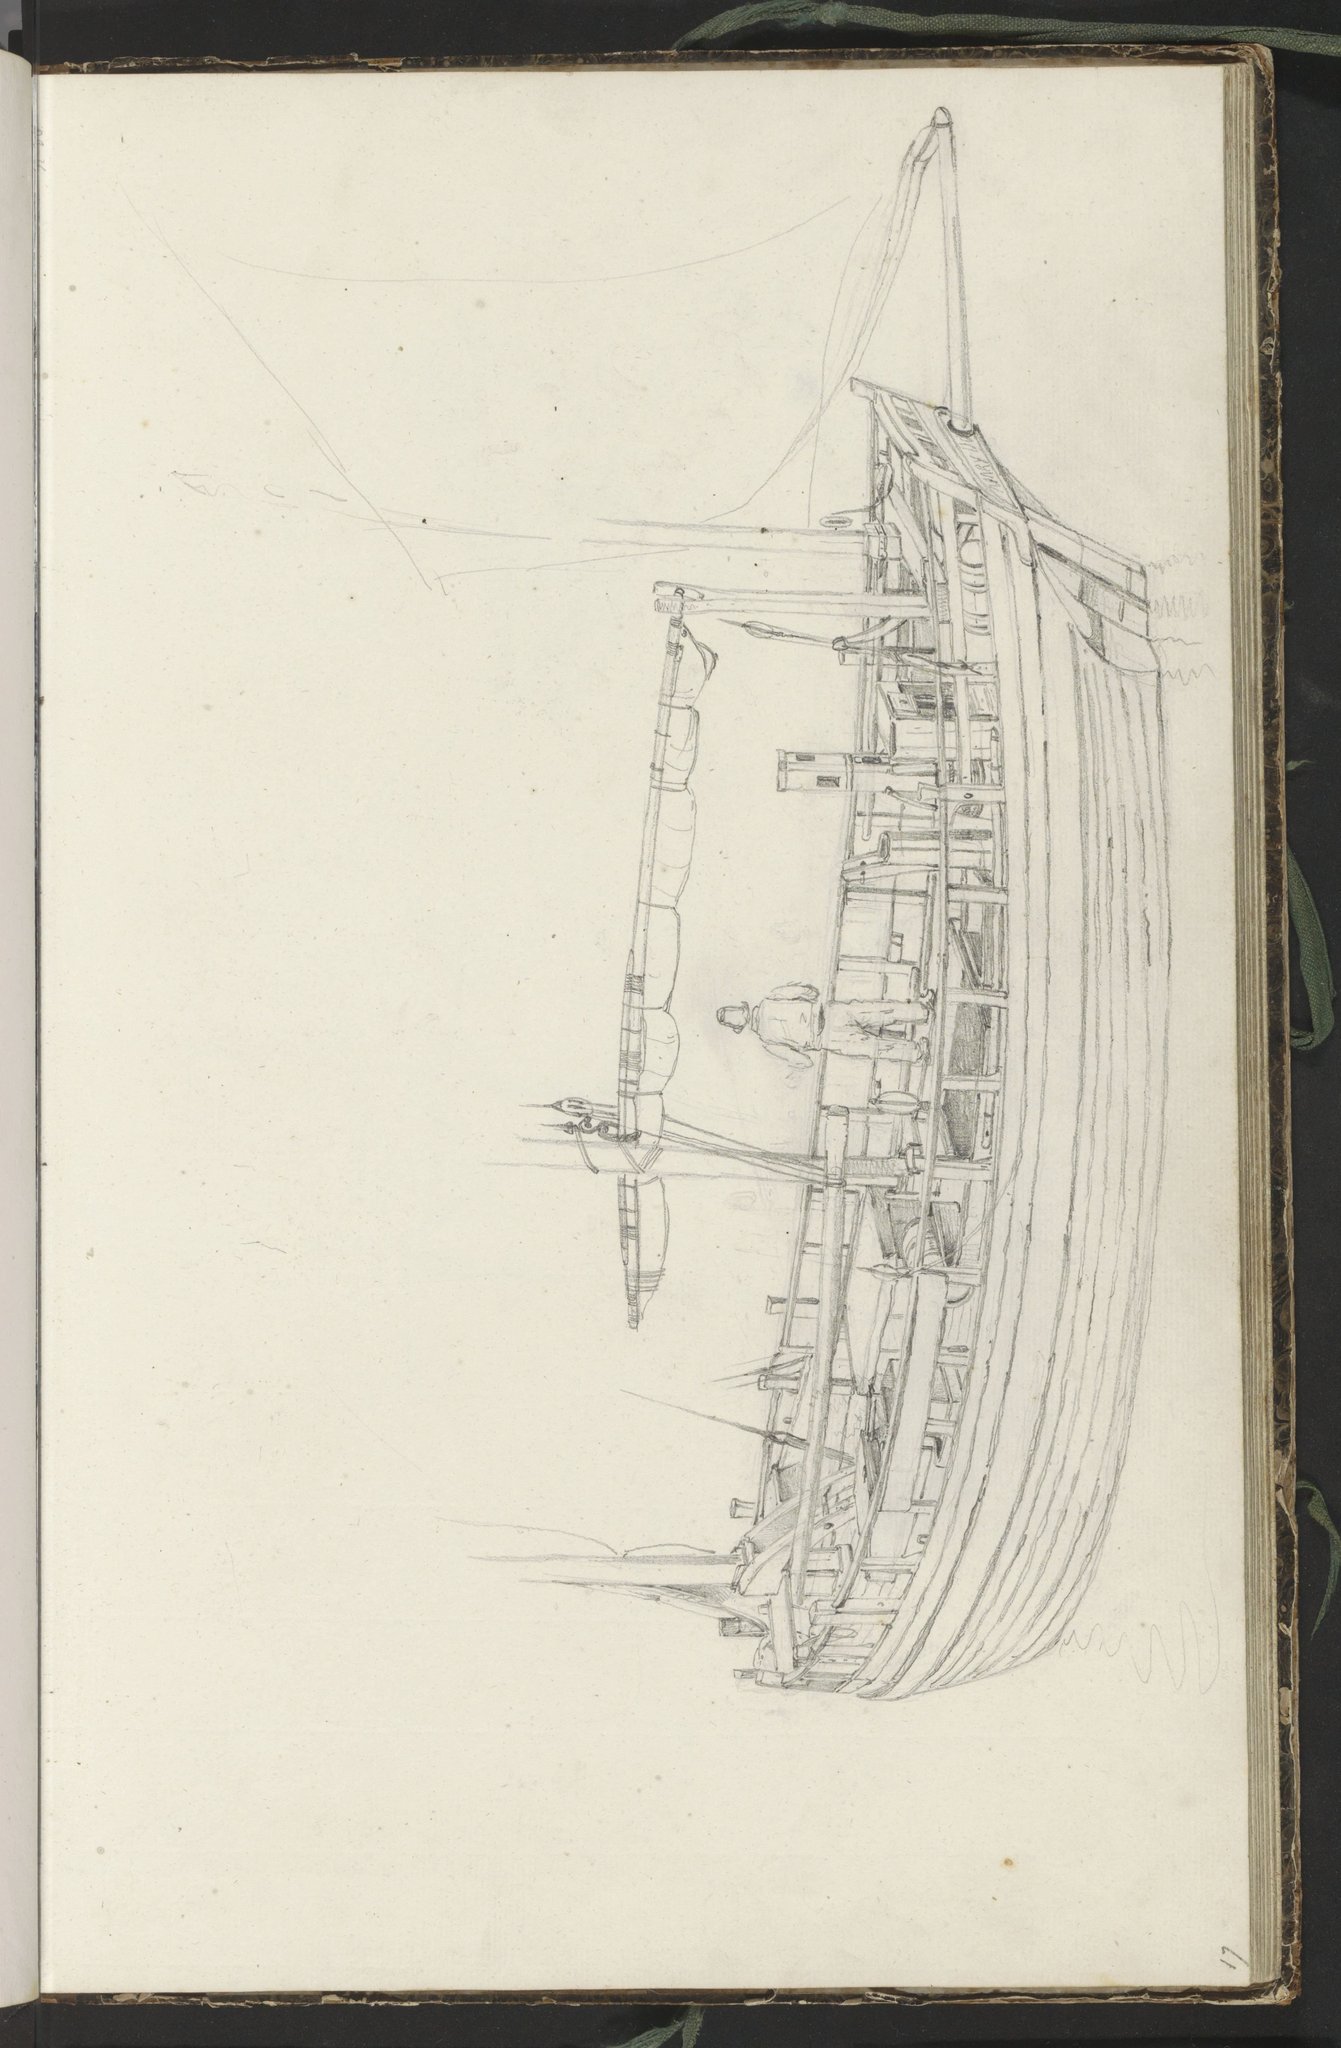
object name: sketchbook leaf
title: Man op een zeilschip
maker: johannes christiaan schotel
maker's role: draughtsman, painter, print maker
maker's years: 1787-1838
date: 1797-1838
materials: paper, pencil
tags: sailing-ship, sailing-boat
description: Blad 17 recto uit een schetsboek met 44 bladen.